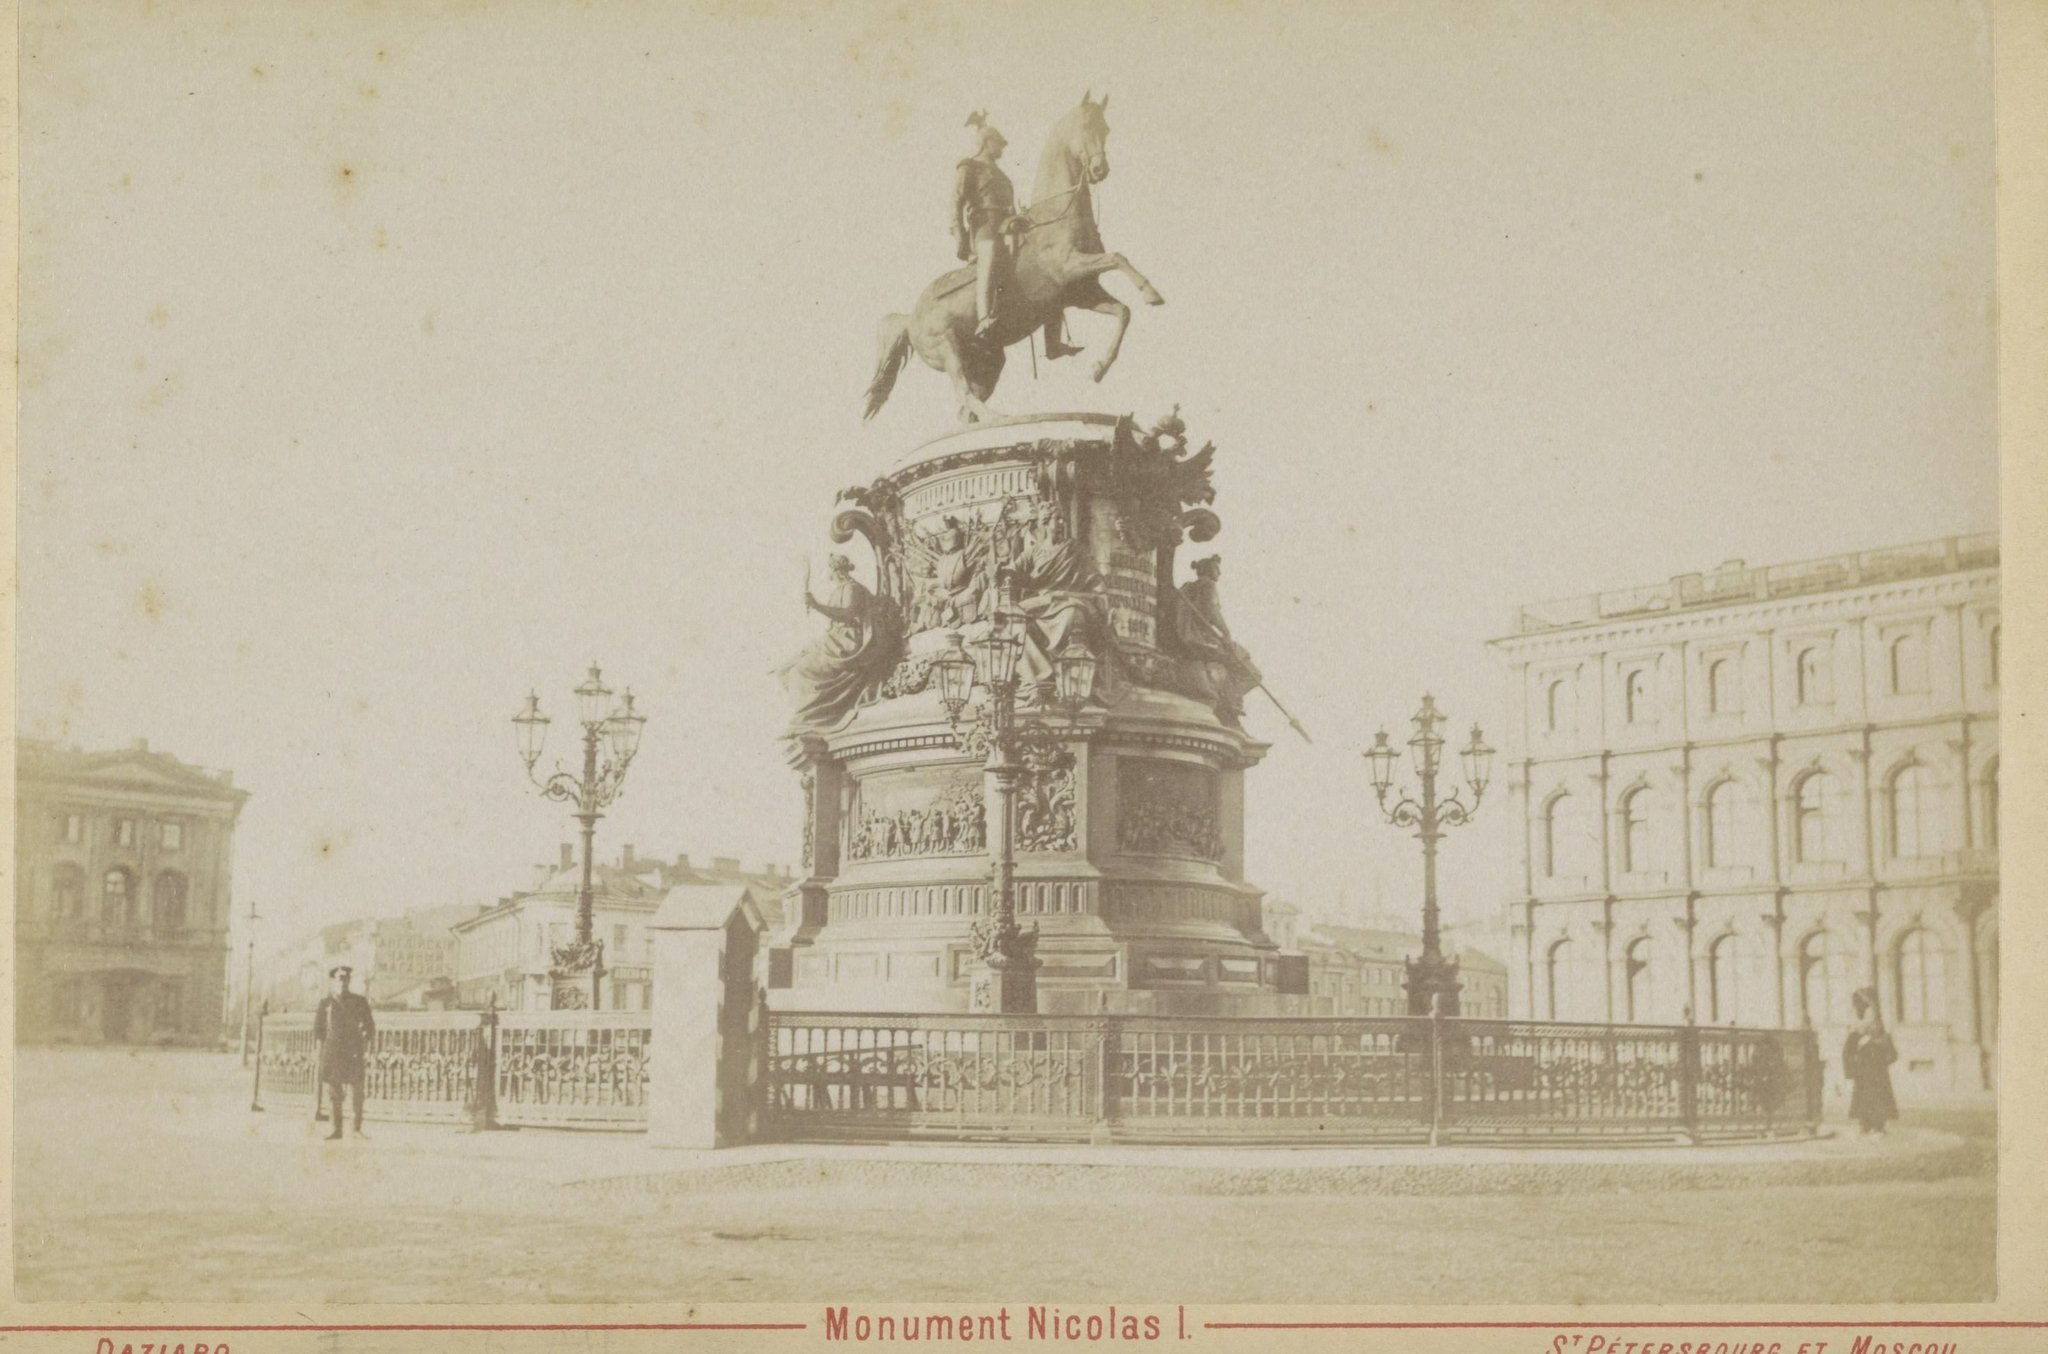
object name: cabinet photograph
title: Ruiterstandbeeld van tsaar Nicolaas I in Sint Petersburg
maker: joseph daziaro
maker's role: publisher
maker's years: 1831-1892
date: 1880-1900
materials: cardboard, photographic support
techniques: albumen print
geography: sint-petersburg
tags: equestrian statue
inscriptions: number: ‘4.’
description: Onderdeel van Leporelloalbum met opnames van Sint-Petersburg.